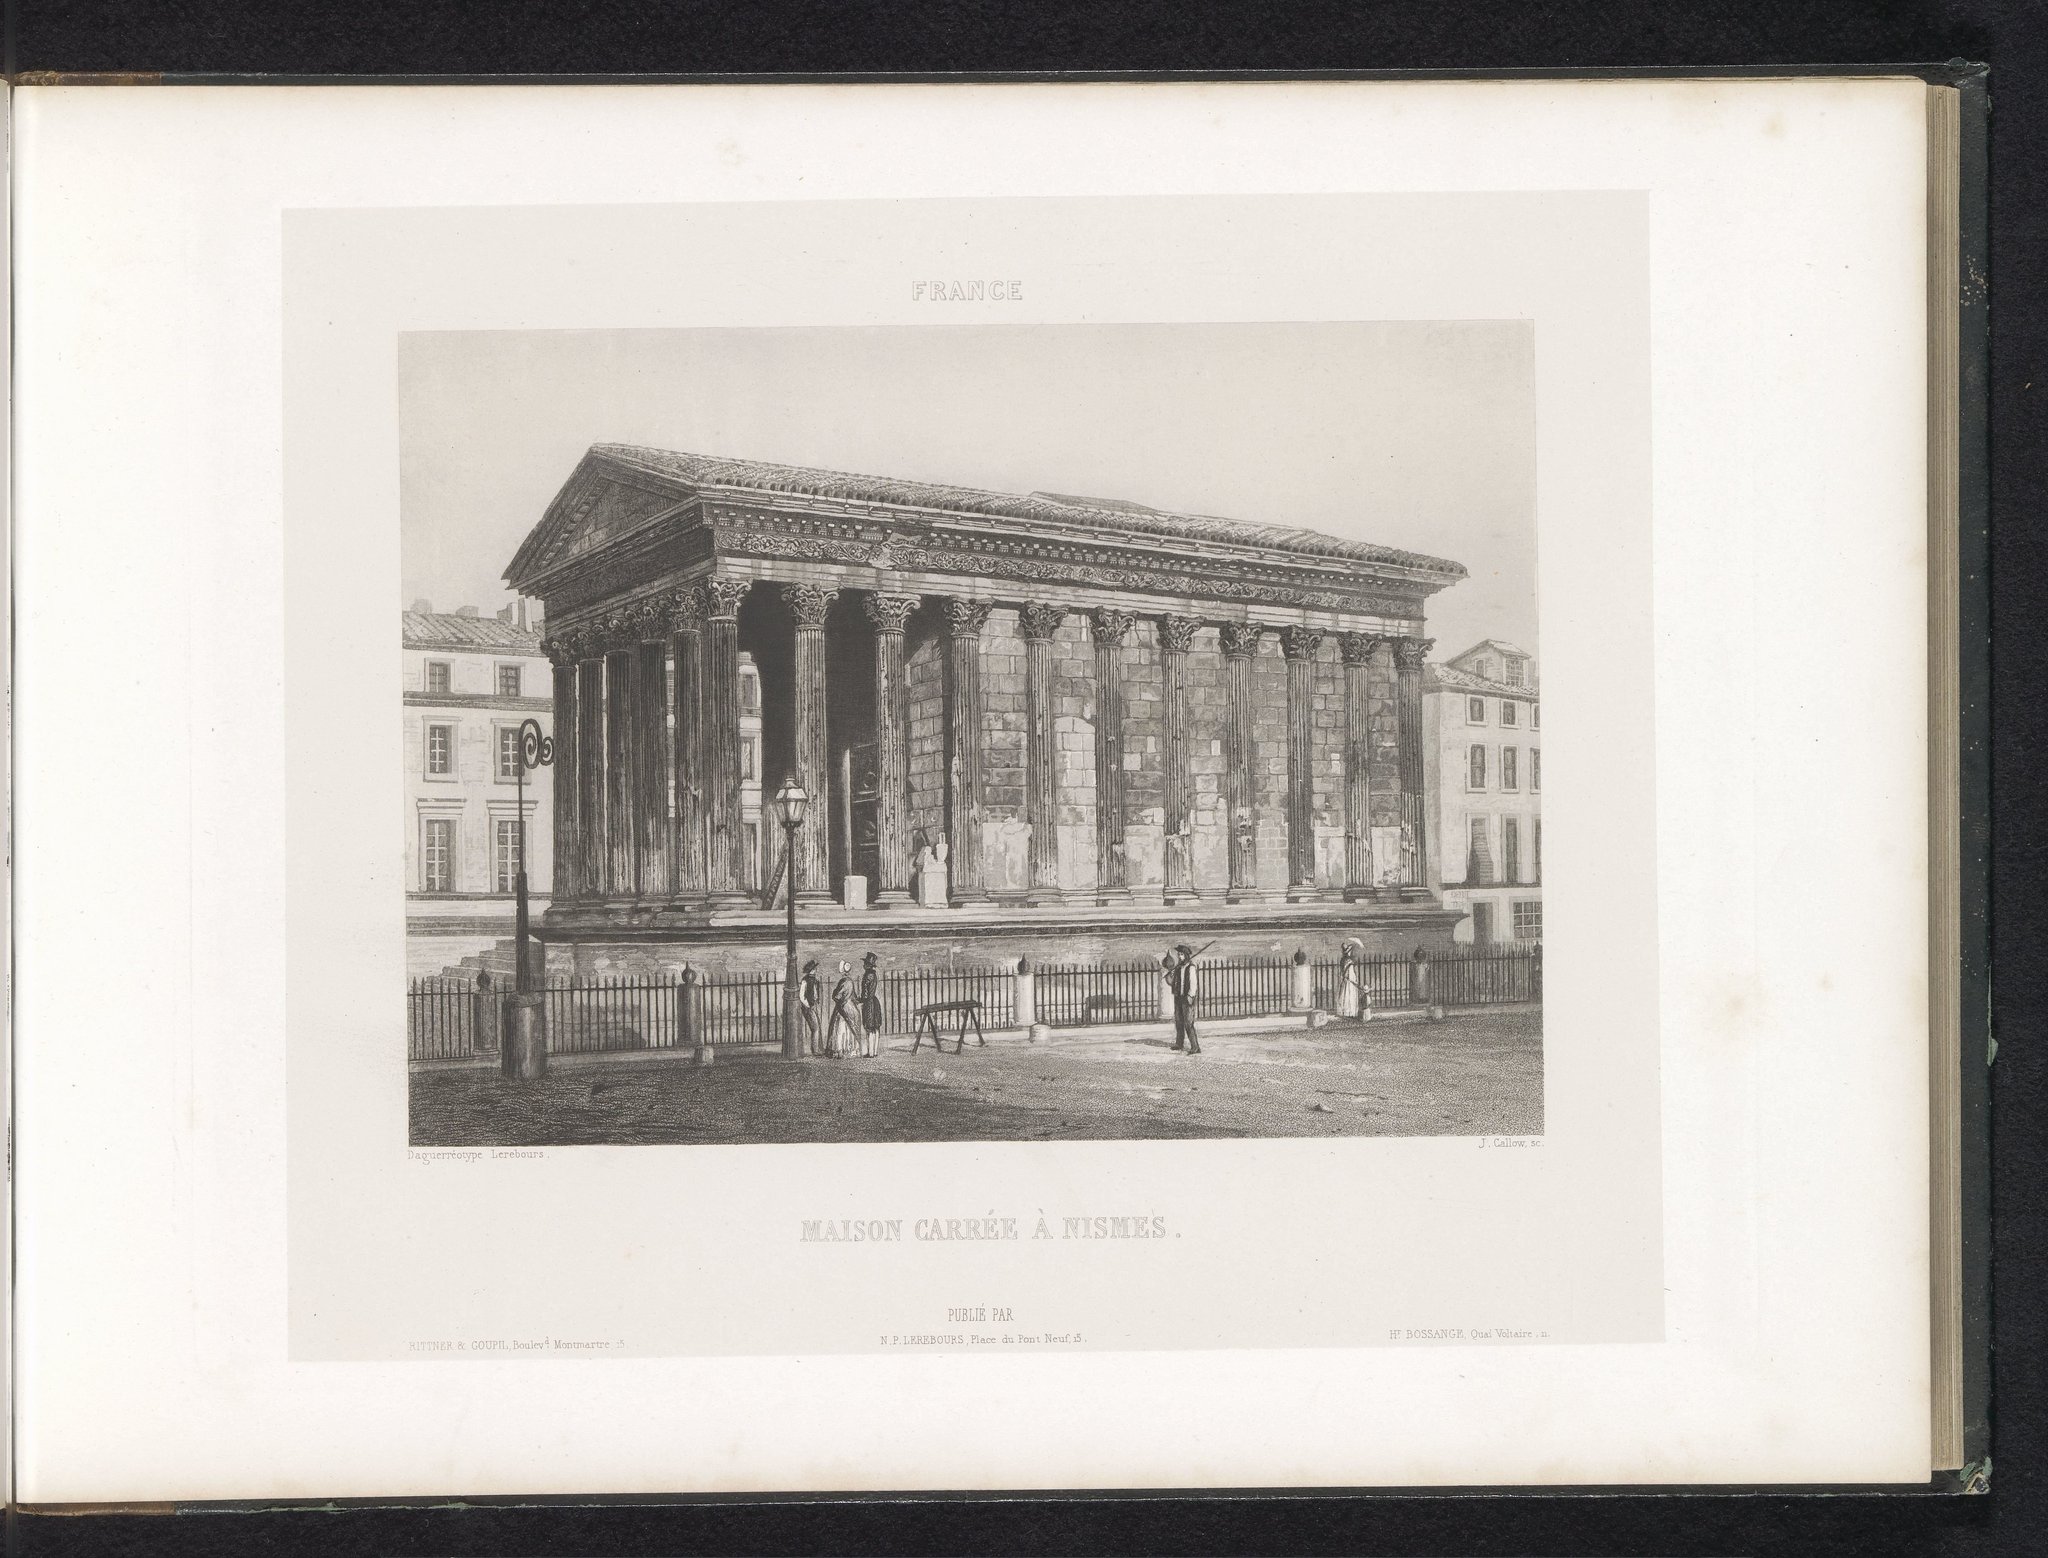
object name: page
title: France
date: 1839-1841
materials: paper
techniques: aquatint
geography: nîmes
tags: temple, shrine ~ roman religion, façade (of house or building)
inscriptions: inscription: ‘N.P. Lerebours Place du Pont Neuf 15’, inscription: ‘Rittner & Goupil Boulevd Montmartre 15’, inscription: ‘Hr. Bossance Quai Voltaire 11’